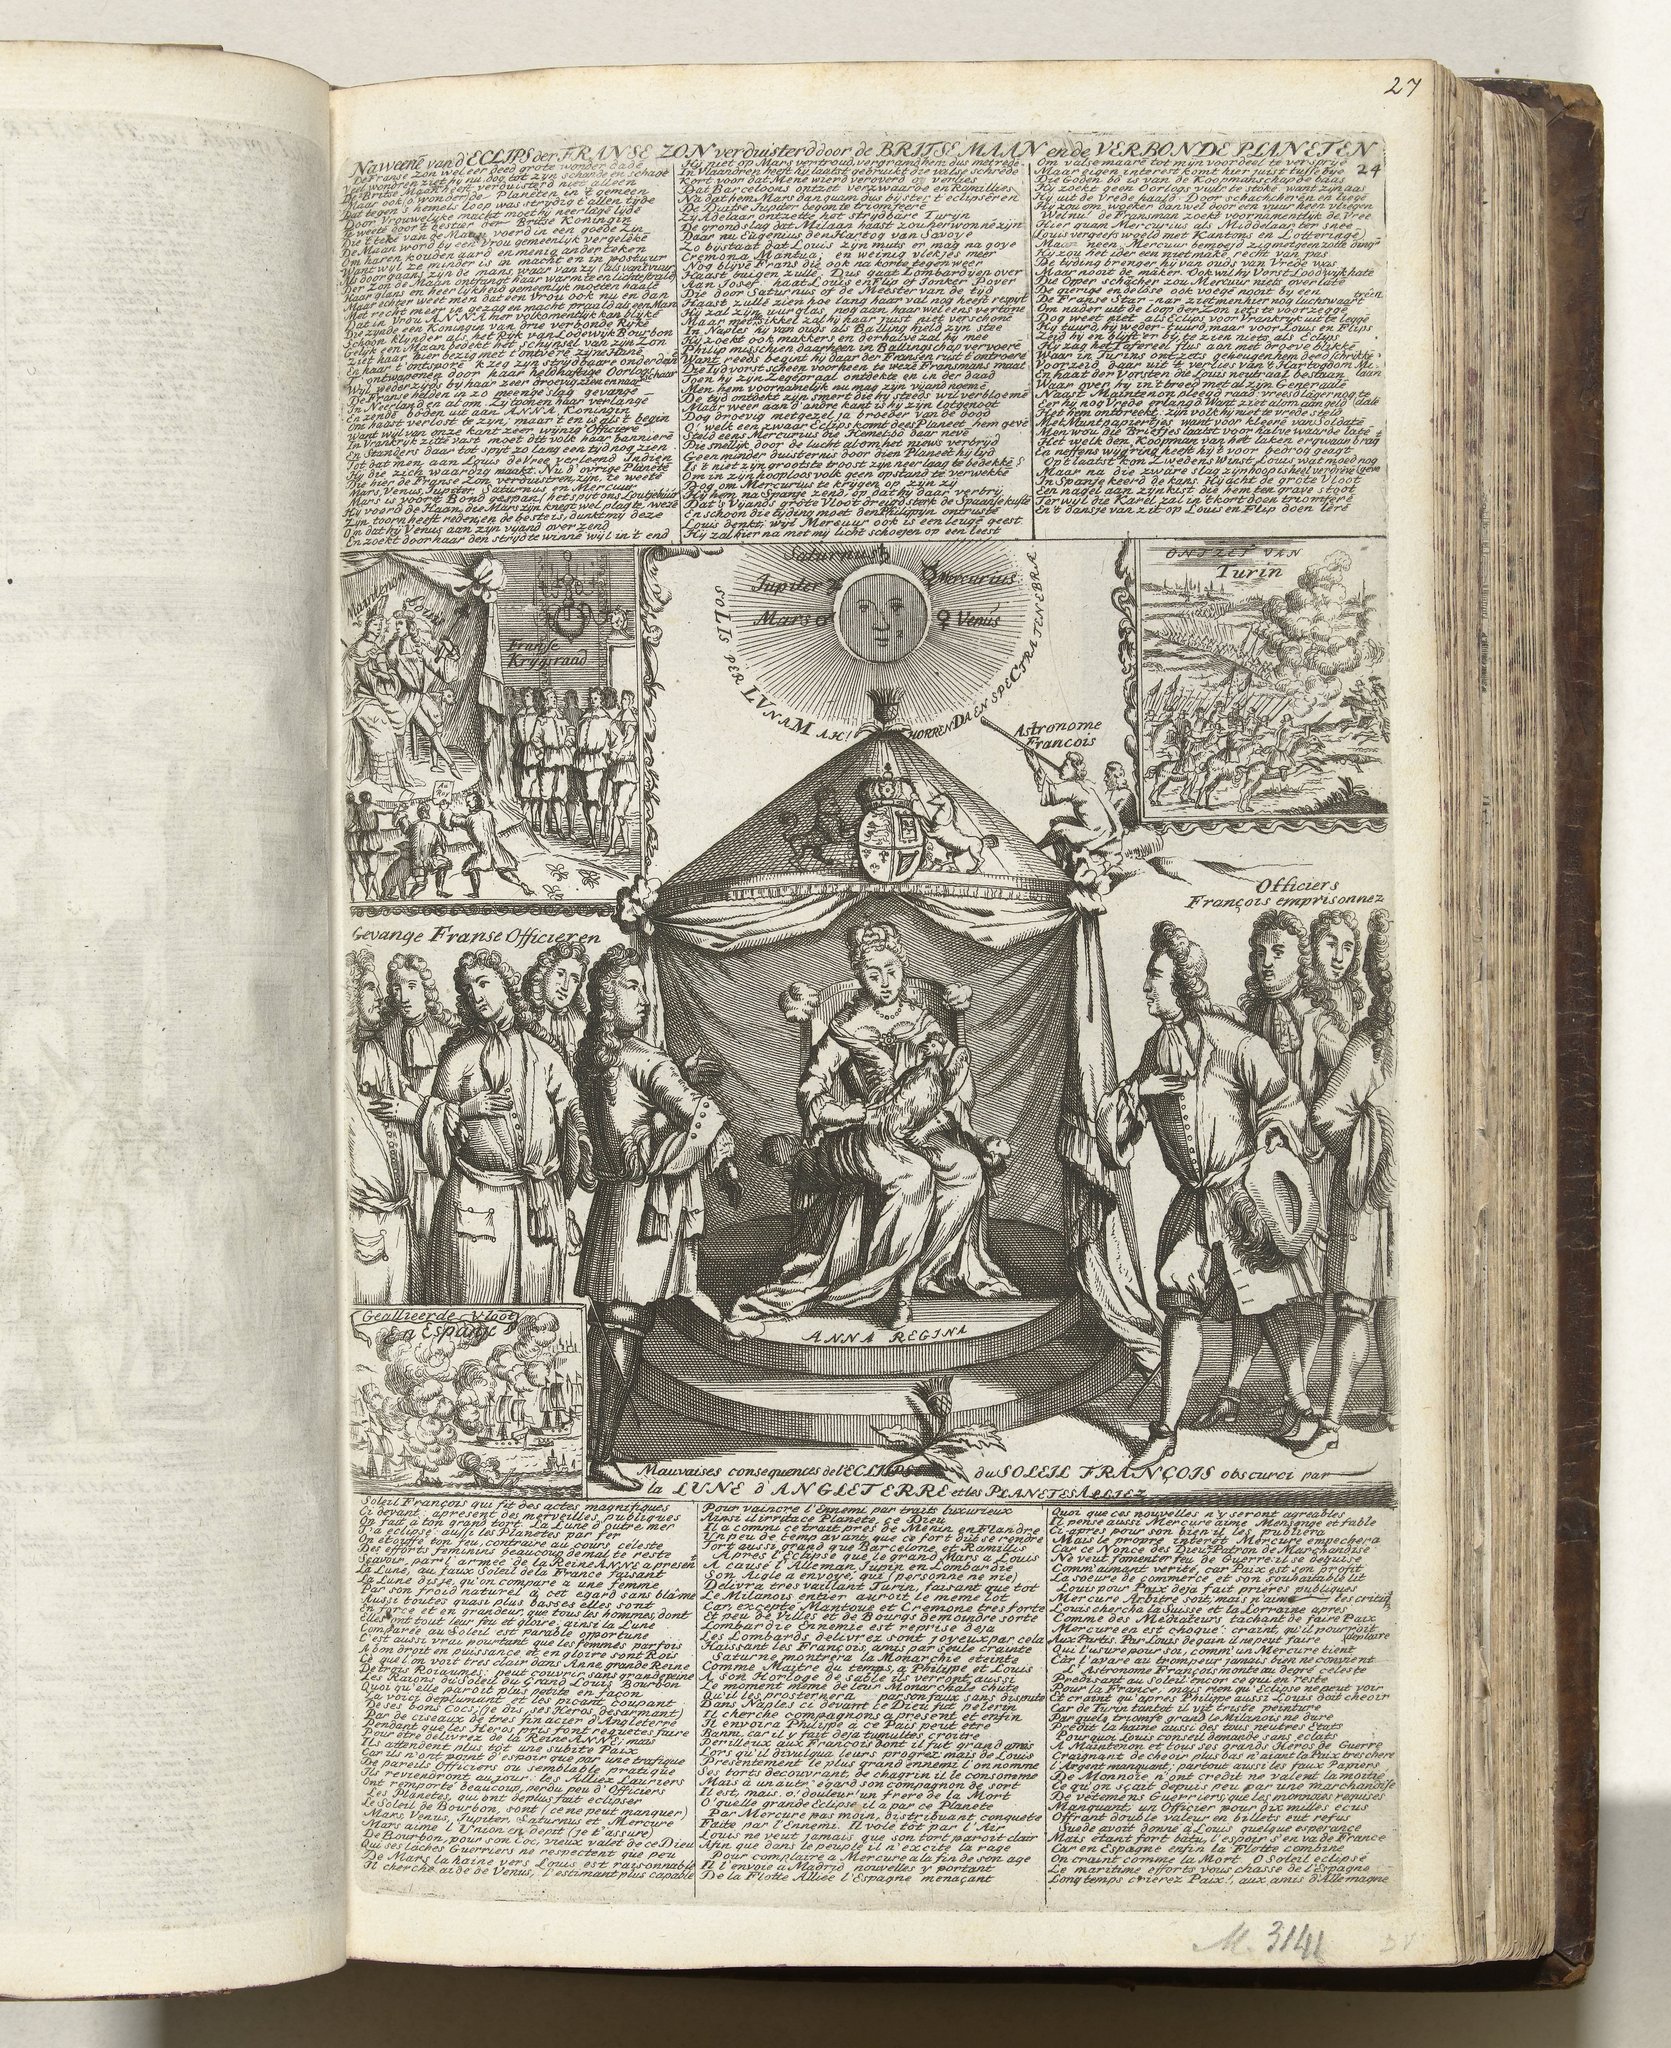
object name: cartoon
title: Koningin Anna plukt de Franse haan, 1706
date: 1706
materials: paper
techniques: etching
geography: northern netherlands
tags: london, anna stuart (koningin van engeland en schotland), plucked fowl, solar eclipse, political caricatures and satires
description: Spotprent waarin de Engelse koningin Anna gezeten op haar troon de Franse haan plukt, aan weerszijden gevangen Franse officieren. Boven de troon de zonsverduistering van 12 mei 1706. Met drie kleine scènes van de Franse nederlagen en Lodewijk XIV samen met Madame de Maintenon op de troon. In de plaat 3 kolommen verzen in het Nederlands en Frans. Blad nr. 24 (genummerd rechtsboven) in de serie van 25 bladen getiteld: Byvoegsel tot de Koninglyke Almanach, genaamd het Gulde-Jaar der Bondgenooten, 1706. Onderdeel van het prentwerk uitgegeven onder de verzameltitel: 't Lust-Hof van Momus, met de gebundelde series van spotprenten tijdens de jaren 1701-1713 van de Spaanse Successieoorlog.